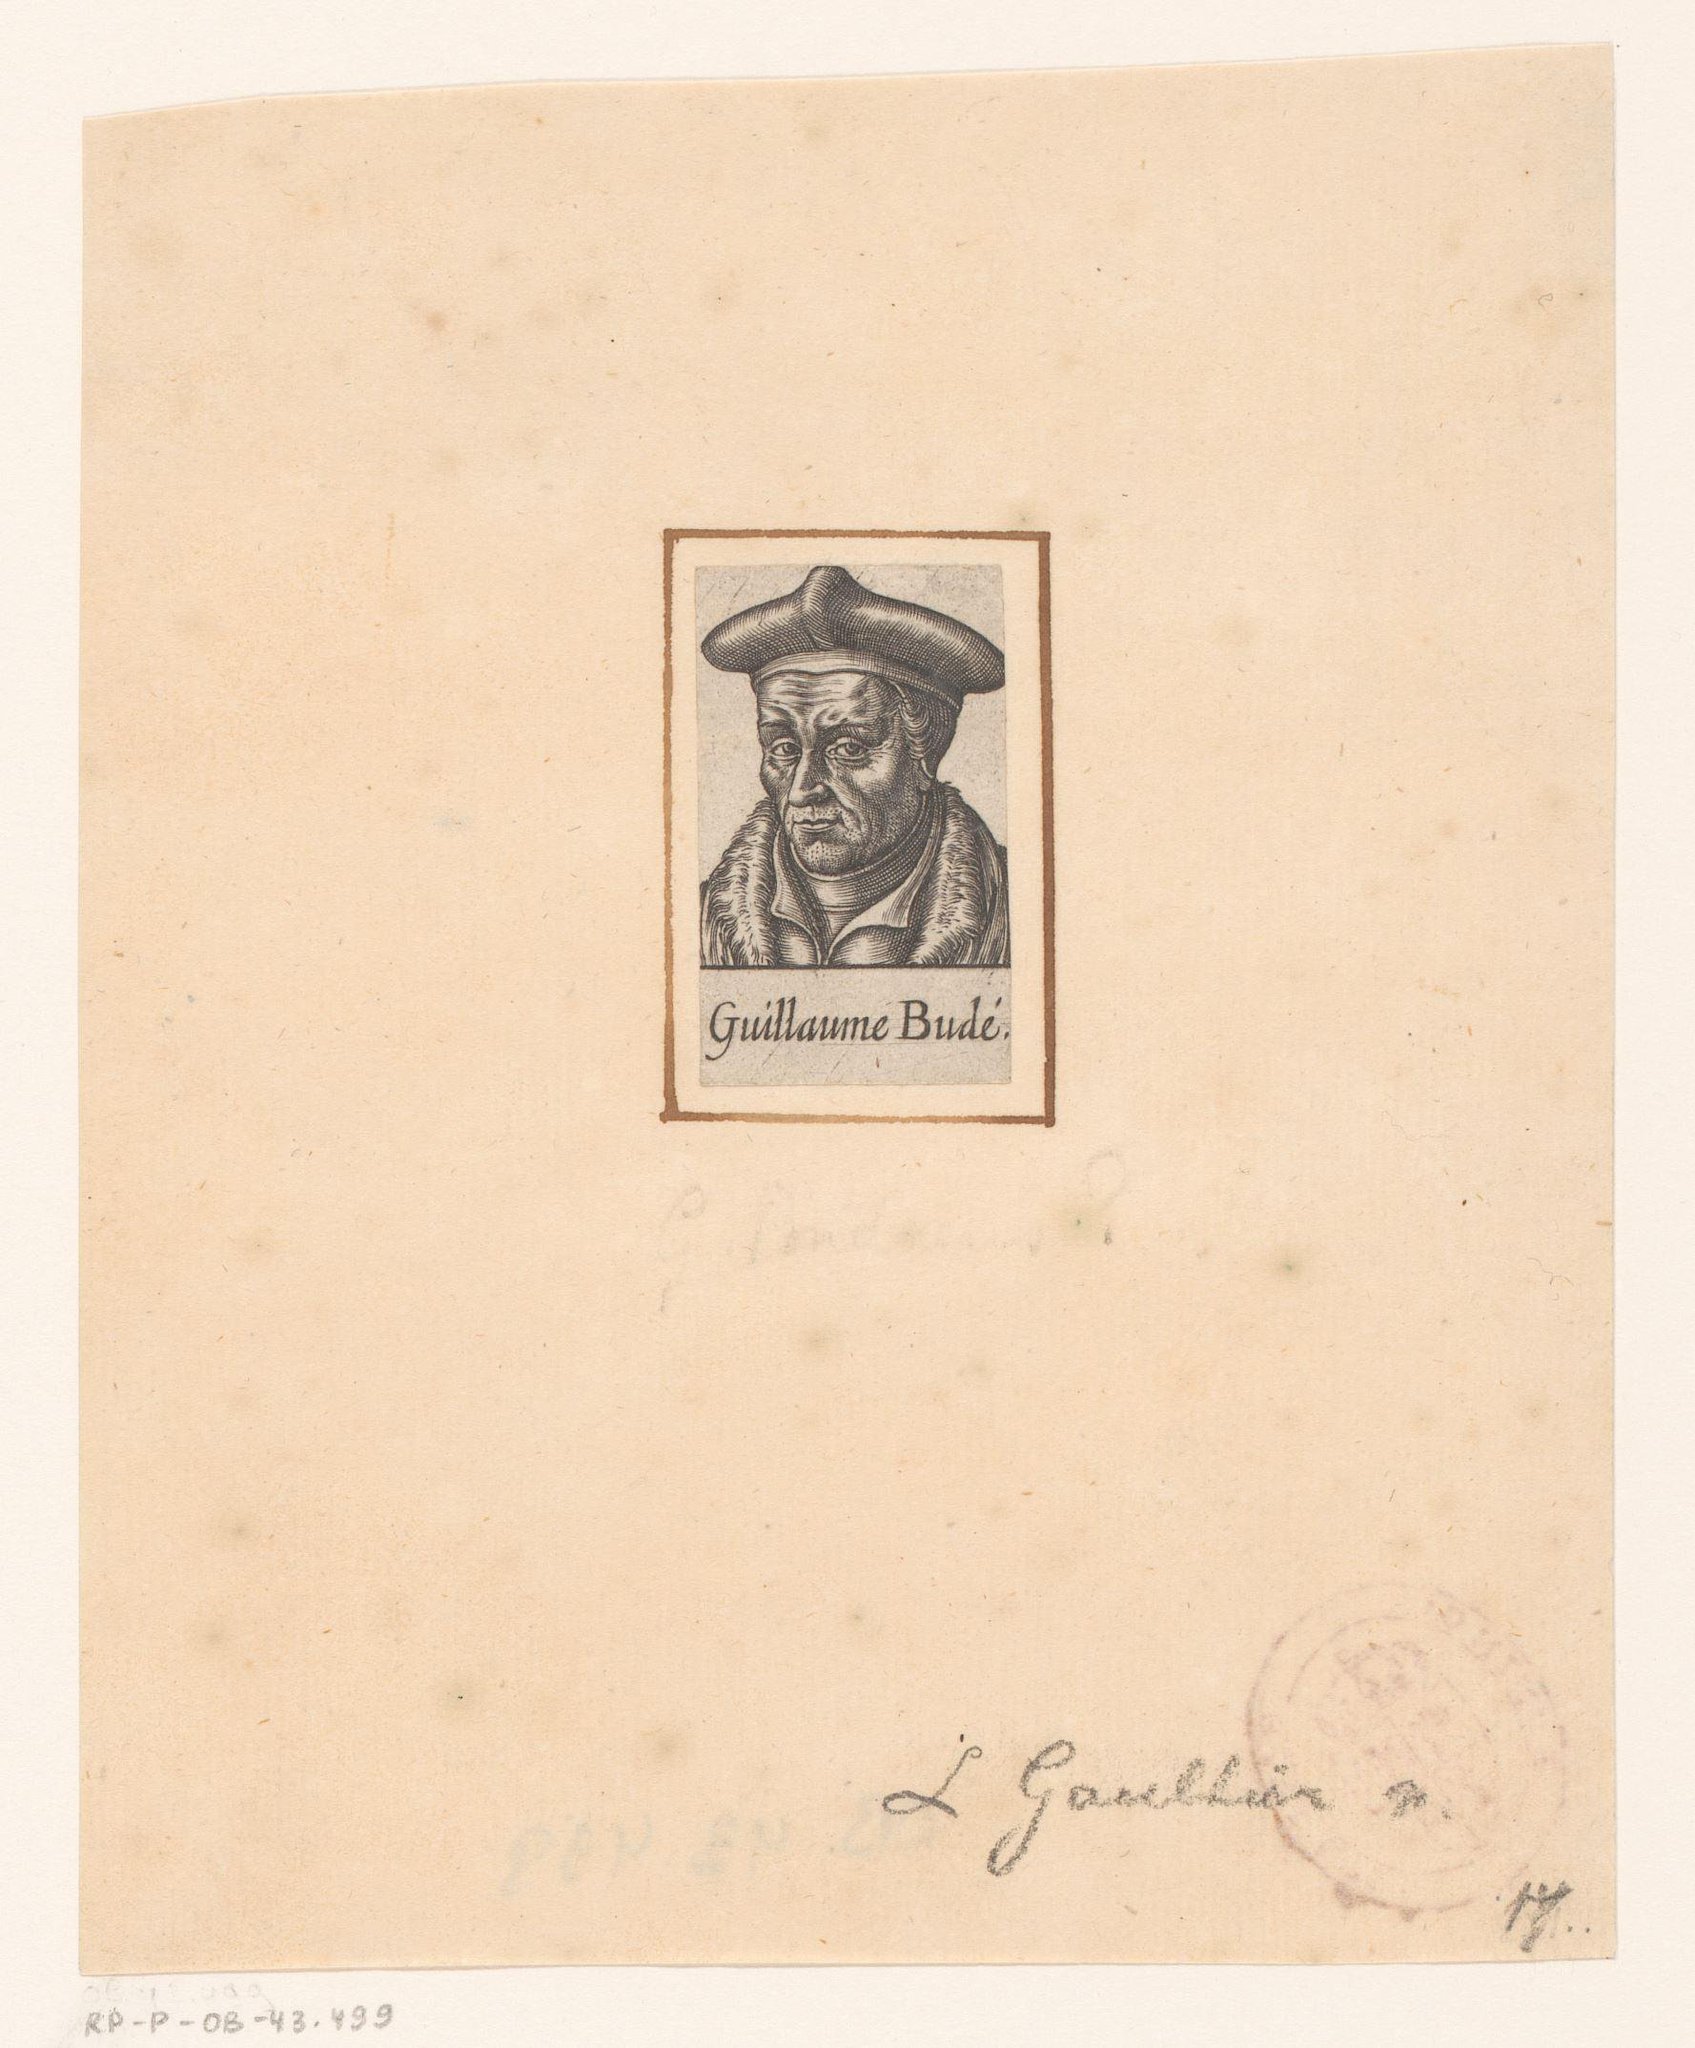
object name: print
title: Guillaume Budé.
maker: leonard gaultier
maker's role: print maker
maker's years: 1561-1641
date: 1571-1641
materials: paper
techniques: engraving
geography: france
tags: paris, historical persons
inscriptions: collector's mark: Lugt 2228, collector's mark: Lugt 240